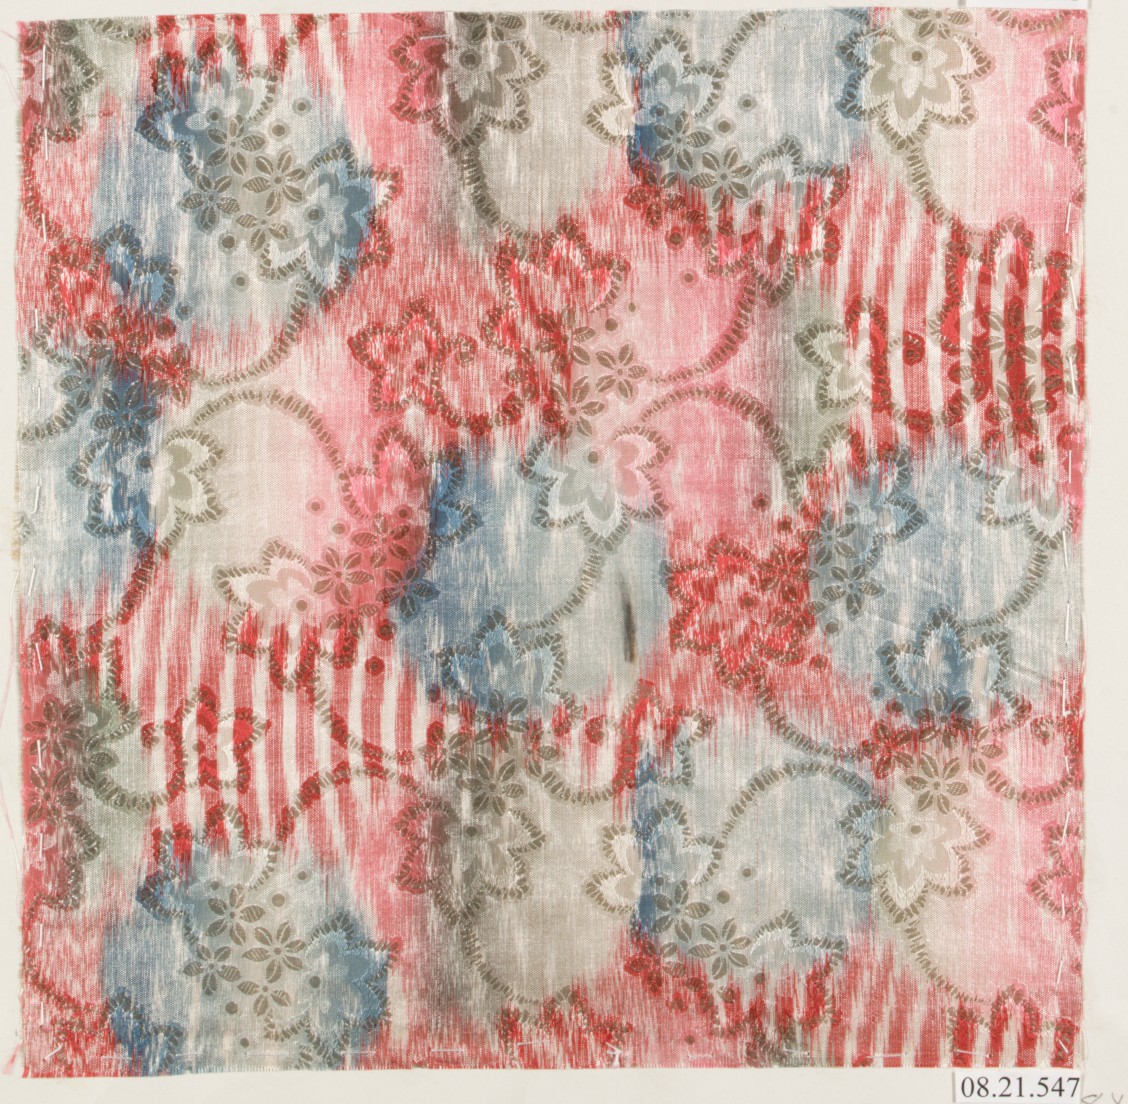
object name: textile sample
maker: Anonymous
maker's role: designer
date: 1900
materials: silk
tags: flowers